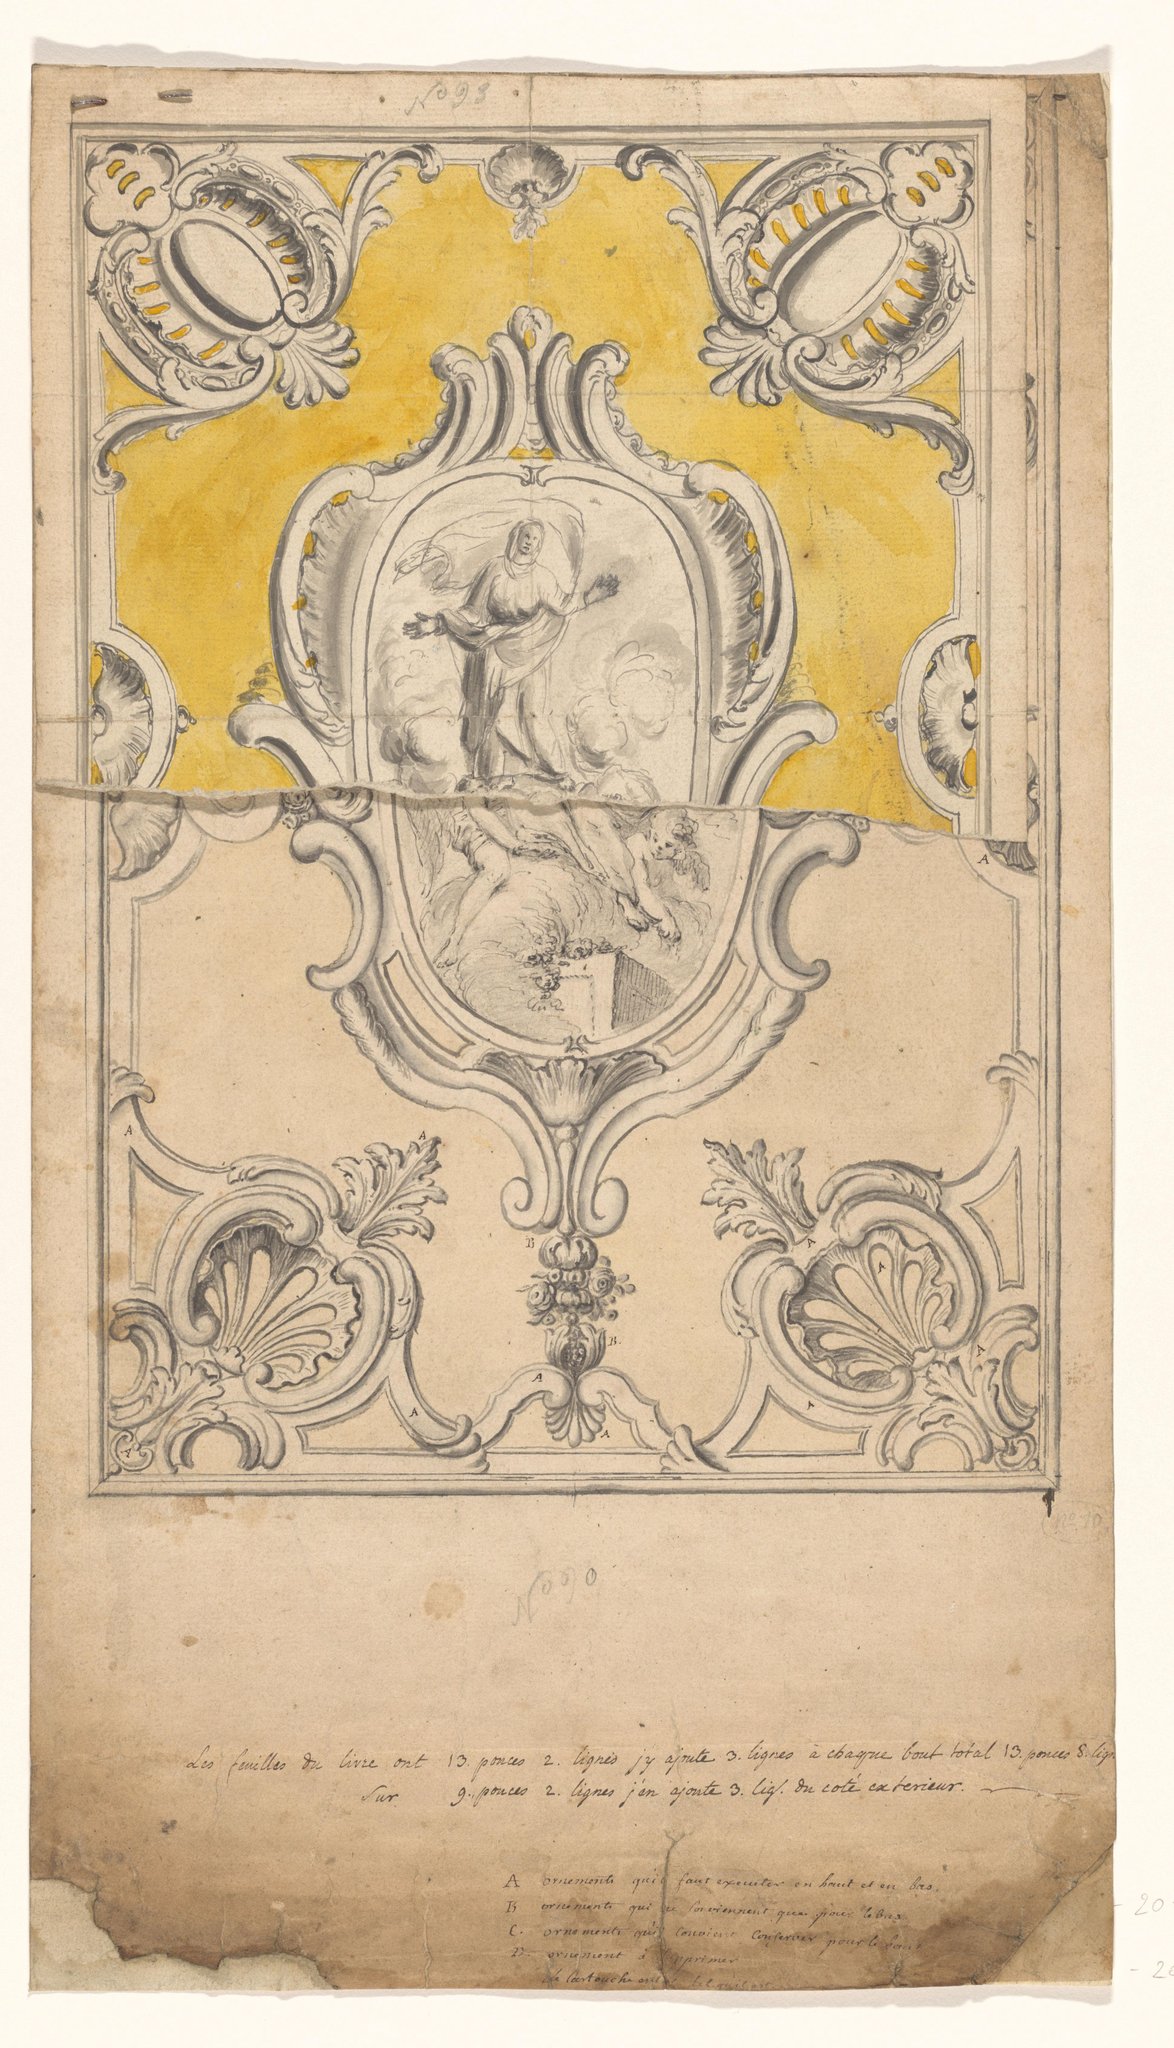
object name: design drawing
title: Ontwerp voor het beslag van een boekband, met de hemelvaart van Maria, met varianten voor de hoekbeslagen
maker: Anonymous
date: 1750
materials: graphite, ink, paper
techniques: brush, pen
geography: paris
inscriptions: inscription: ‘Les feuilles du livre ont 13. pouces 2. lignes j’y ajoute 3. lignes à chaque bout total 13. pouces 8. lignes / sur 9. pouces 2. lignes j’en ajoute 3 lig. du coté exterieur. / A ornements qu’il faut exécuter en haut et en bas. / B ornements qui ne conviennent que pour le bas / C. ornements qu’il convient conserver pour le haut / D. ornement à supprimer / Le Cartouche entir tel qu’il est.’, watermark, inscription, inscription: ‘A, B, C, D’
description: De voorstelling van de hemelvaart van Maria door een andere hand. Door spijker samengevoegd met RP-T-2019-357.